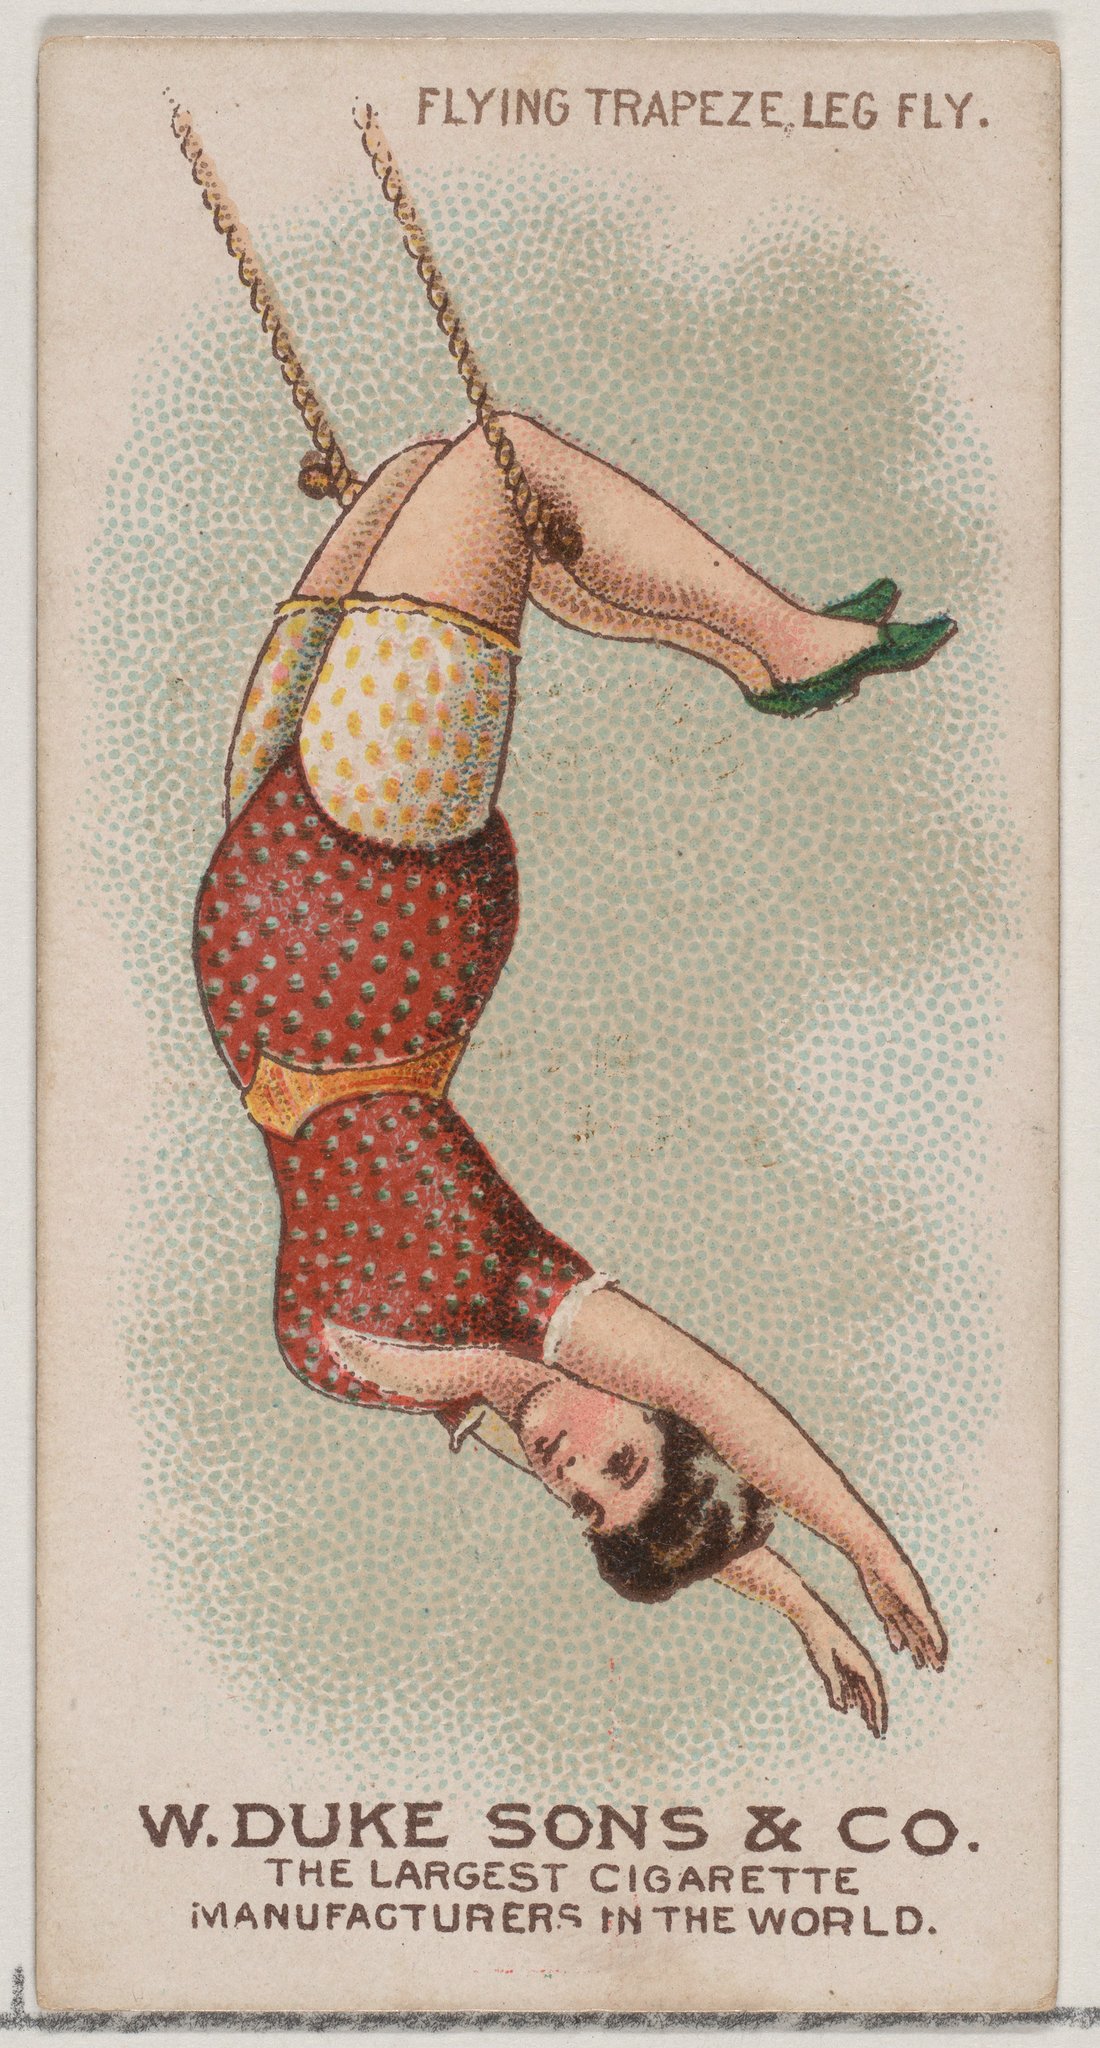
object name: print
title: Flying Trapeze Leg Fly, from the Gymnastic Exercises series (N77) for Duke brand cigarettes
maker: w. duke, sons & co.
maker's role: publisher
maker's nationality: american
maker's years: 1870-1920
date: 1887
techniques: color lithograph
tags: women,sports,athletes